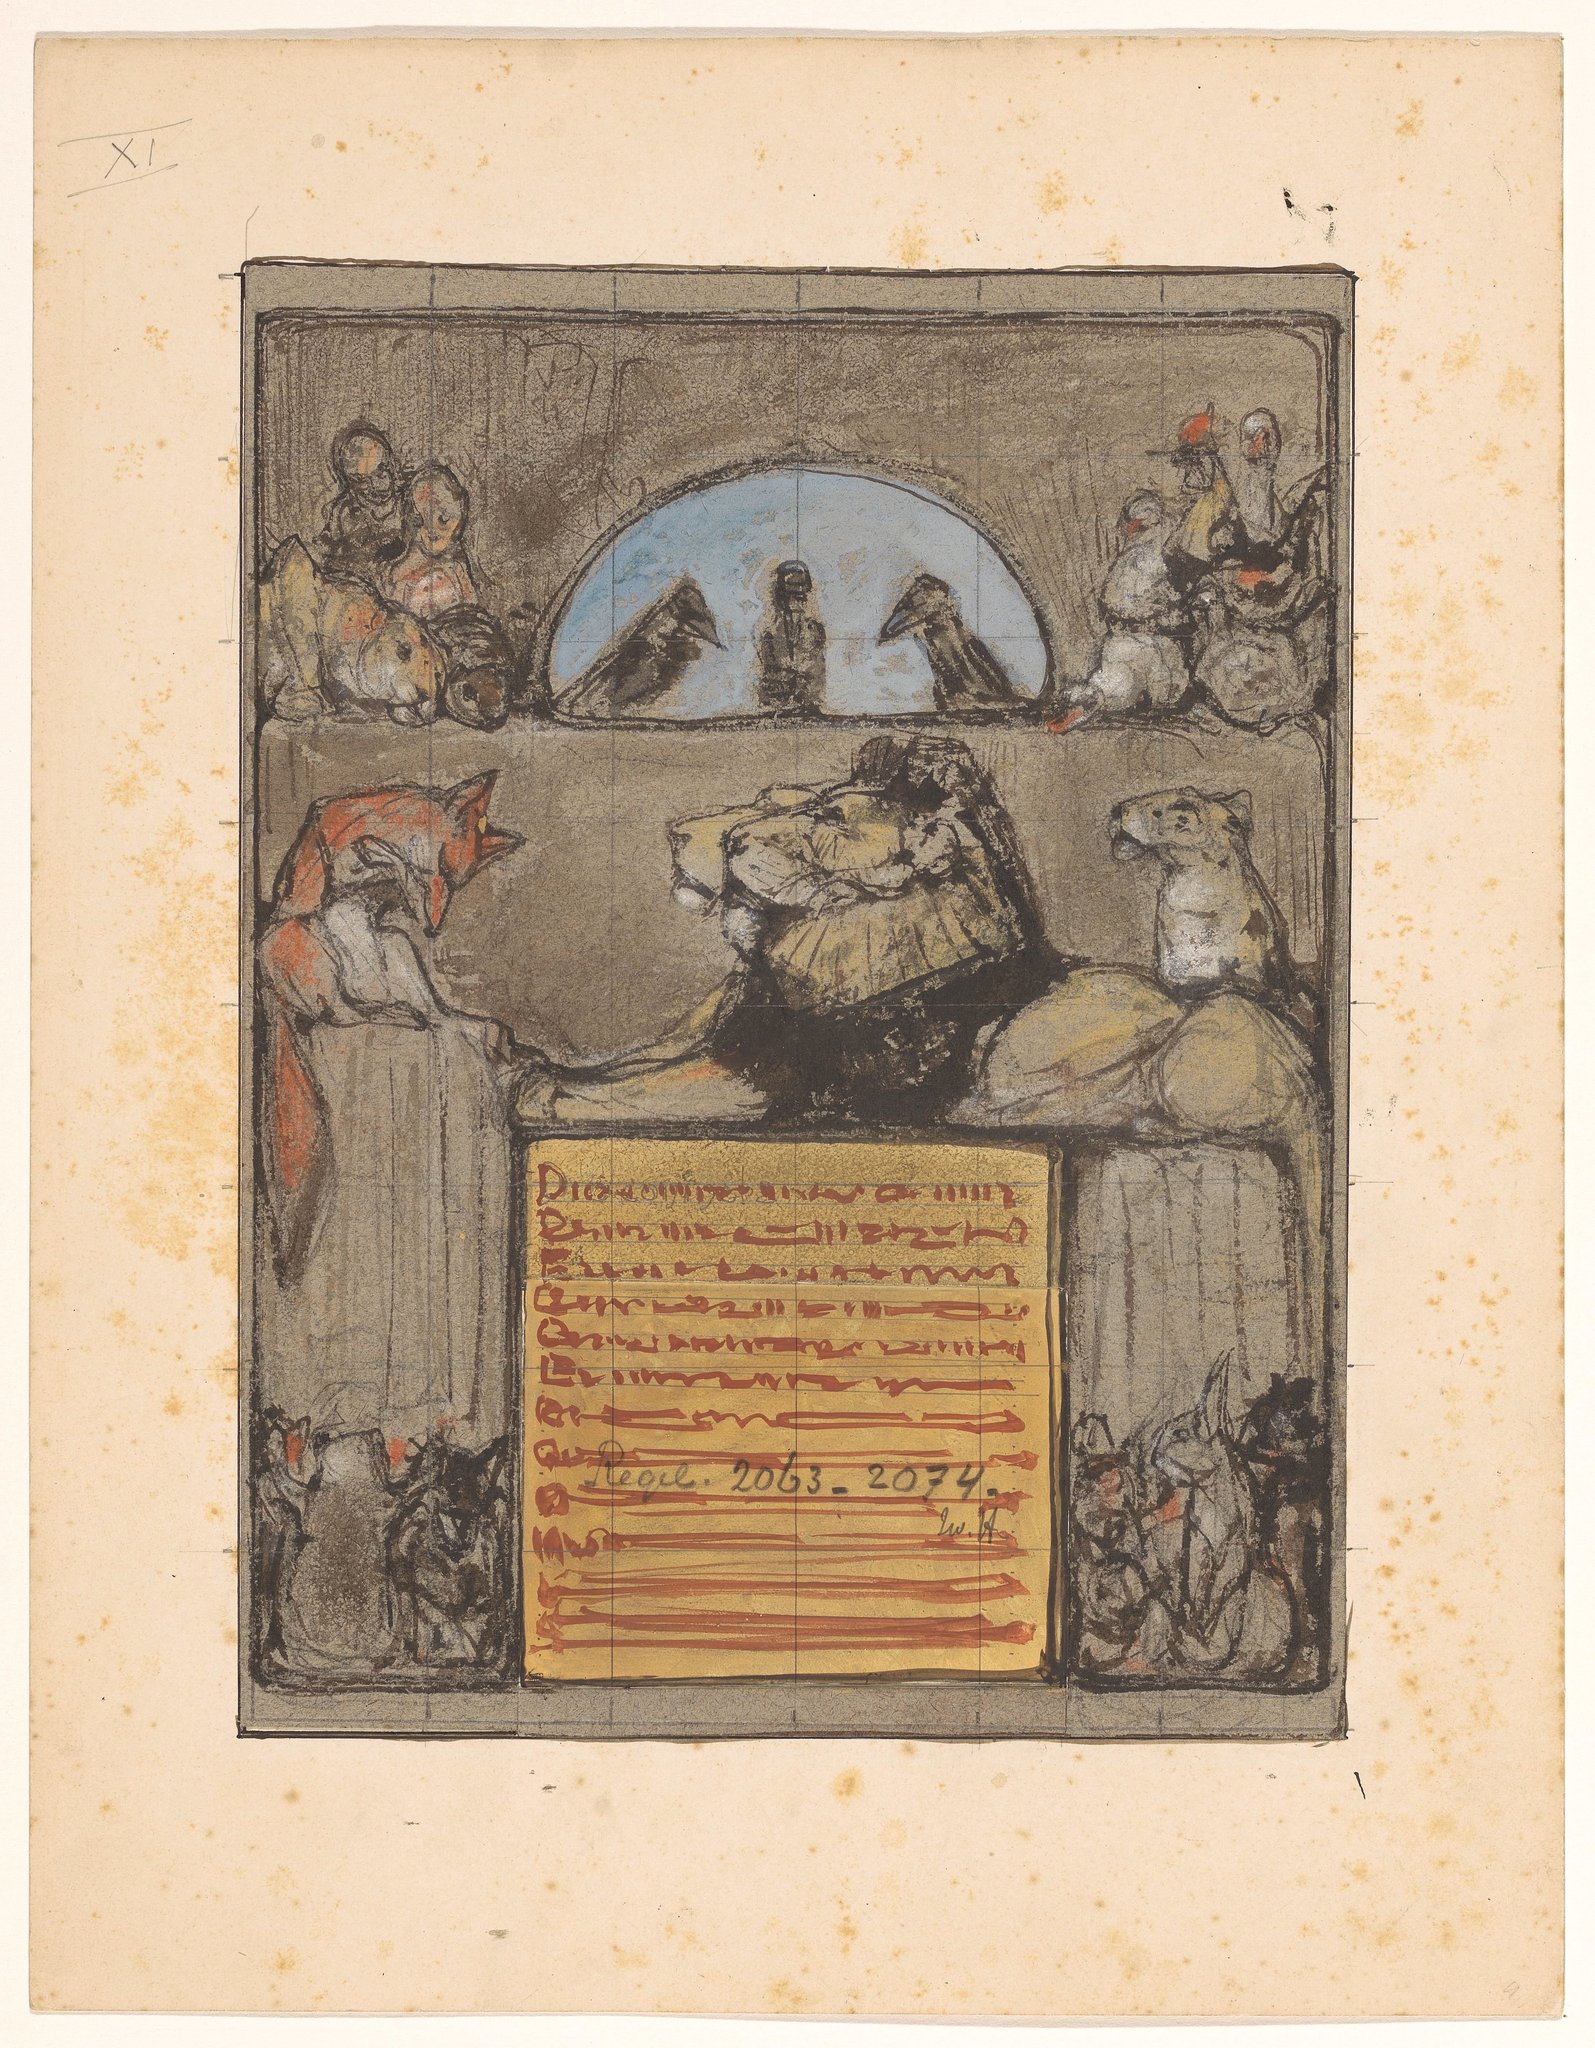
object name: design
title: Reinaert buigt voor koning Nobel en de verzamelde dieren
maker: bernard willem wierink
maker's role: draughtsman, print maker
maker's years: 1856-1939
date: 1866-1939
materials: cardboard, chalk, ink, paper, pencil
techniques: brush, pen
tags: fable of reynard the fox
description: Ontwerp voor illustratie (fol. 11, tweede ontwerp): Van den Vos Reinaerde; Reinaert buigt voor koning Nobel en de verzamelde dieren.